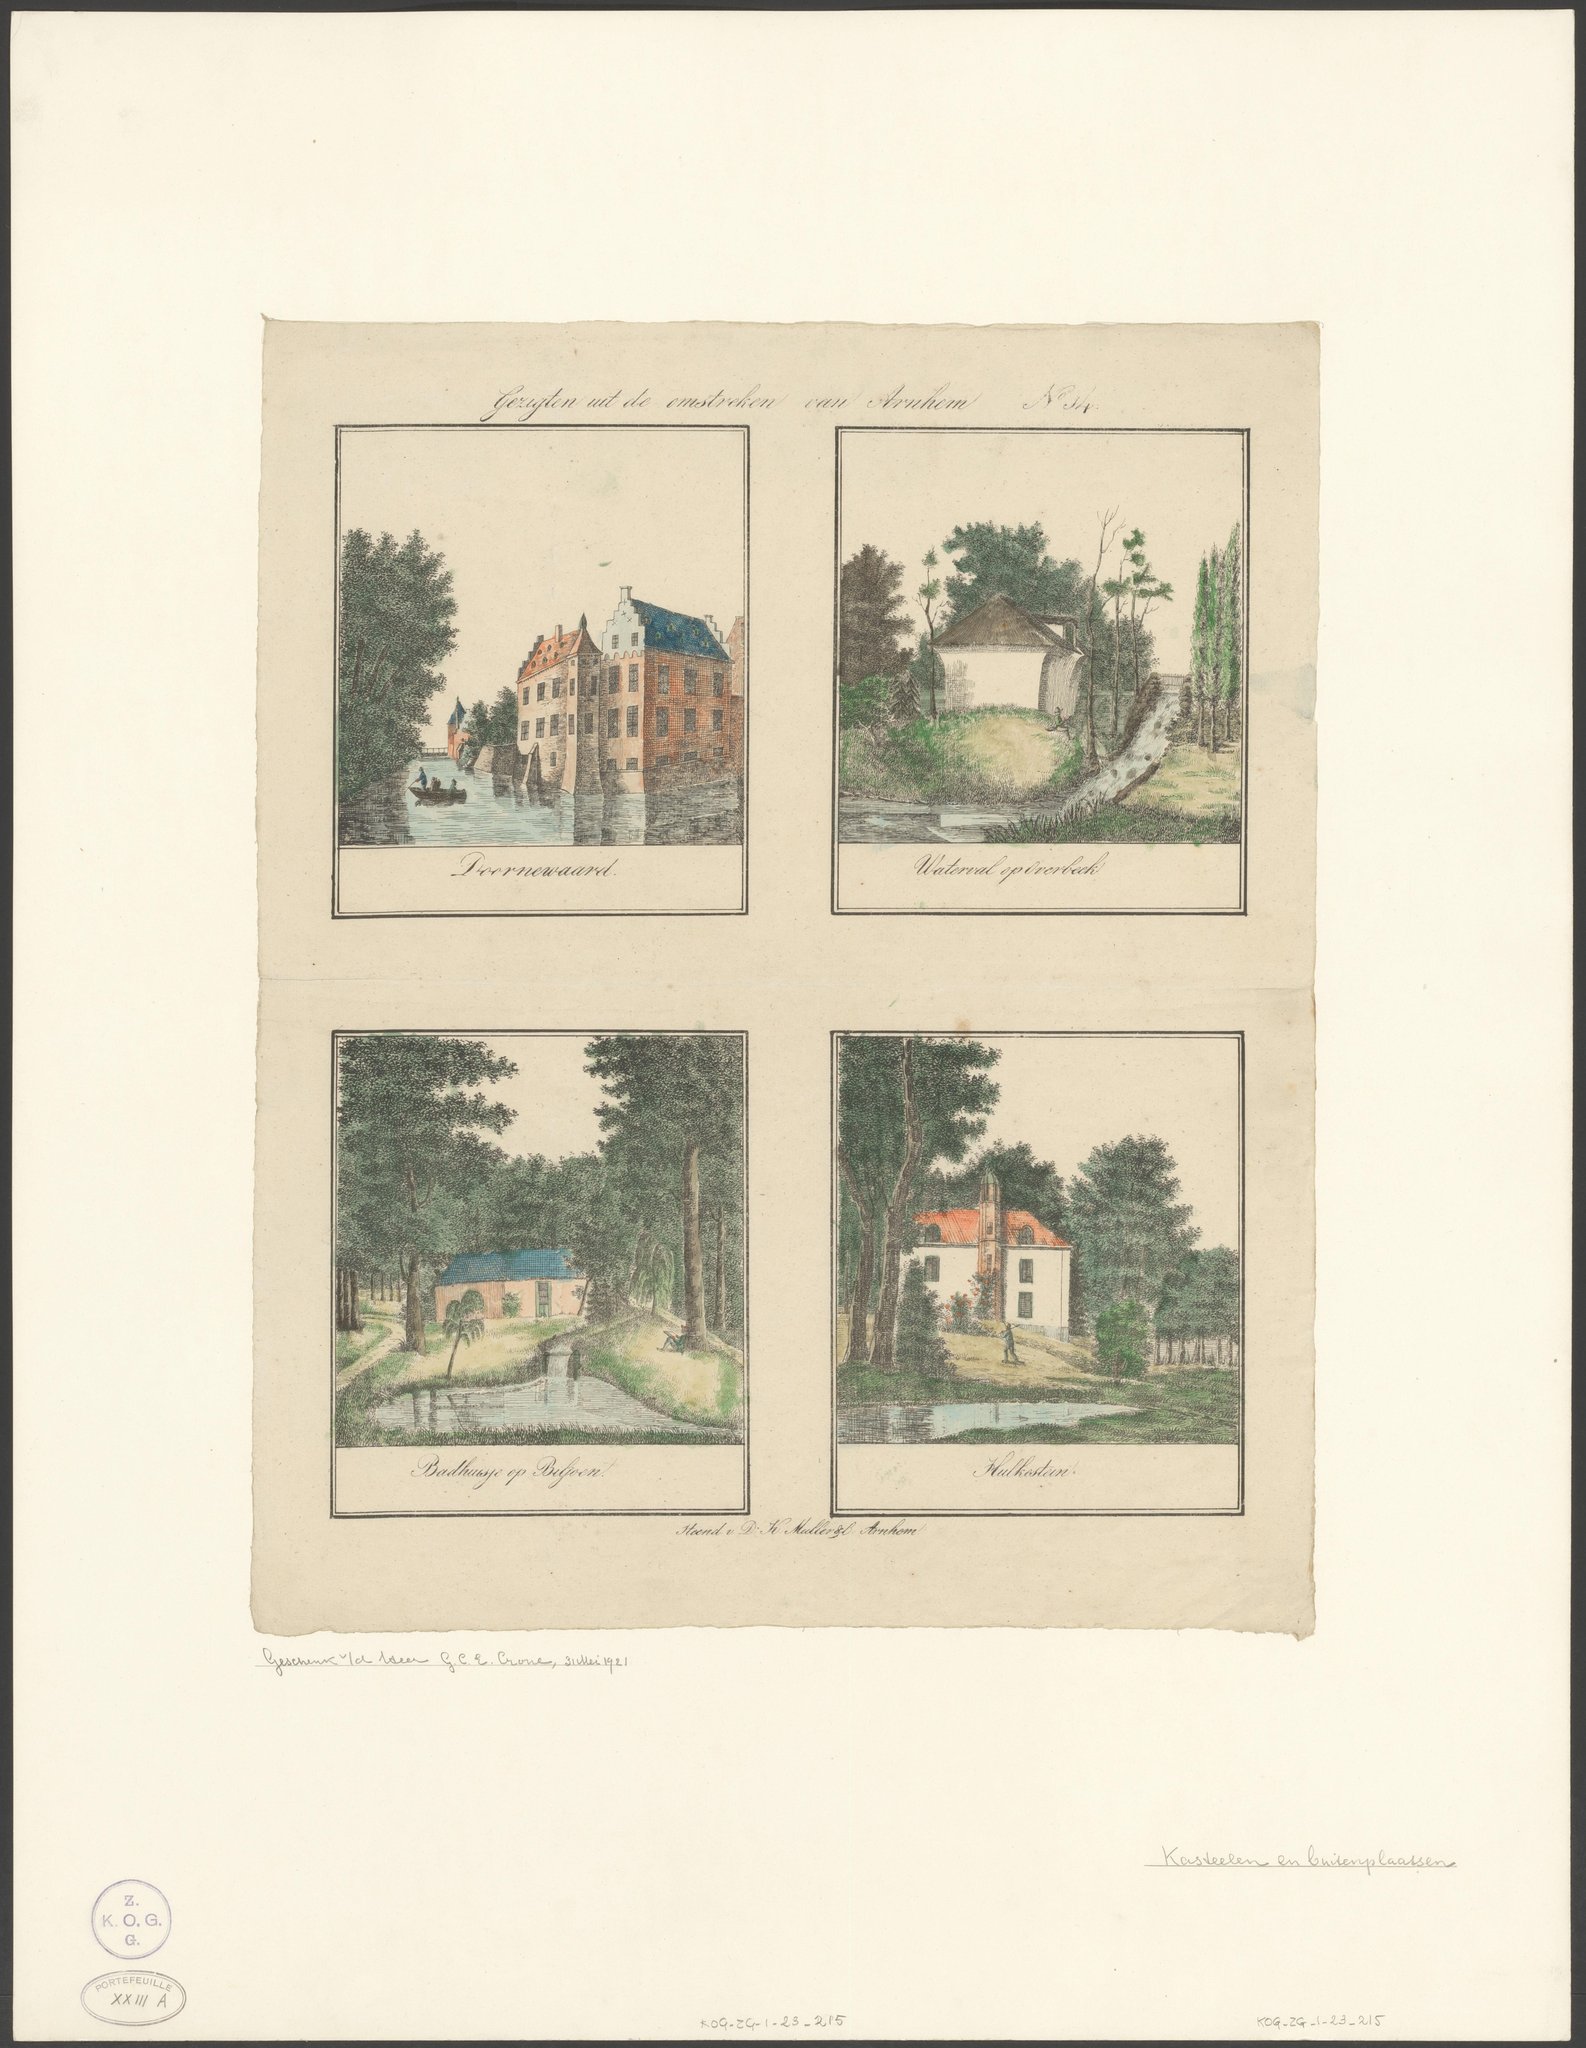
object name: print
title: Gezigten uit de omstreken van Arnhem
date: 1821-1834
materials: paper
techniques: hand coloring, lithograph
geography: arnhem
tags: castle, waterfall, gelderland, arnhem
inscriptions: stamp, collector's mark: Lugt 1641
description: Bovenaan genummerd: No 14. Onderwerpsrubrieken binnen de Atlas Zeden en Gewoonten: Zeden en gewoonten in Engeren zin, De woning, Kastelen en buitenplaatsen.